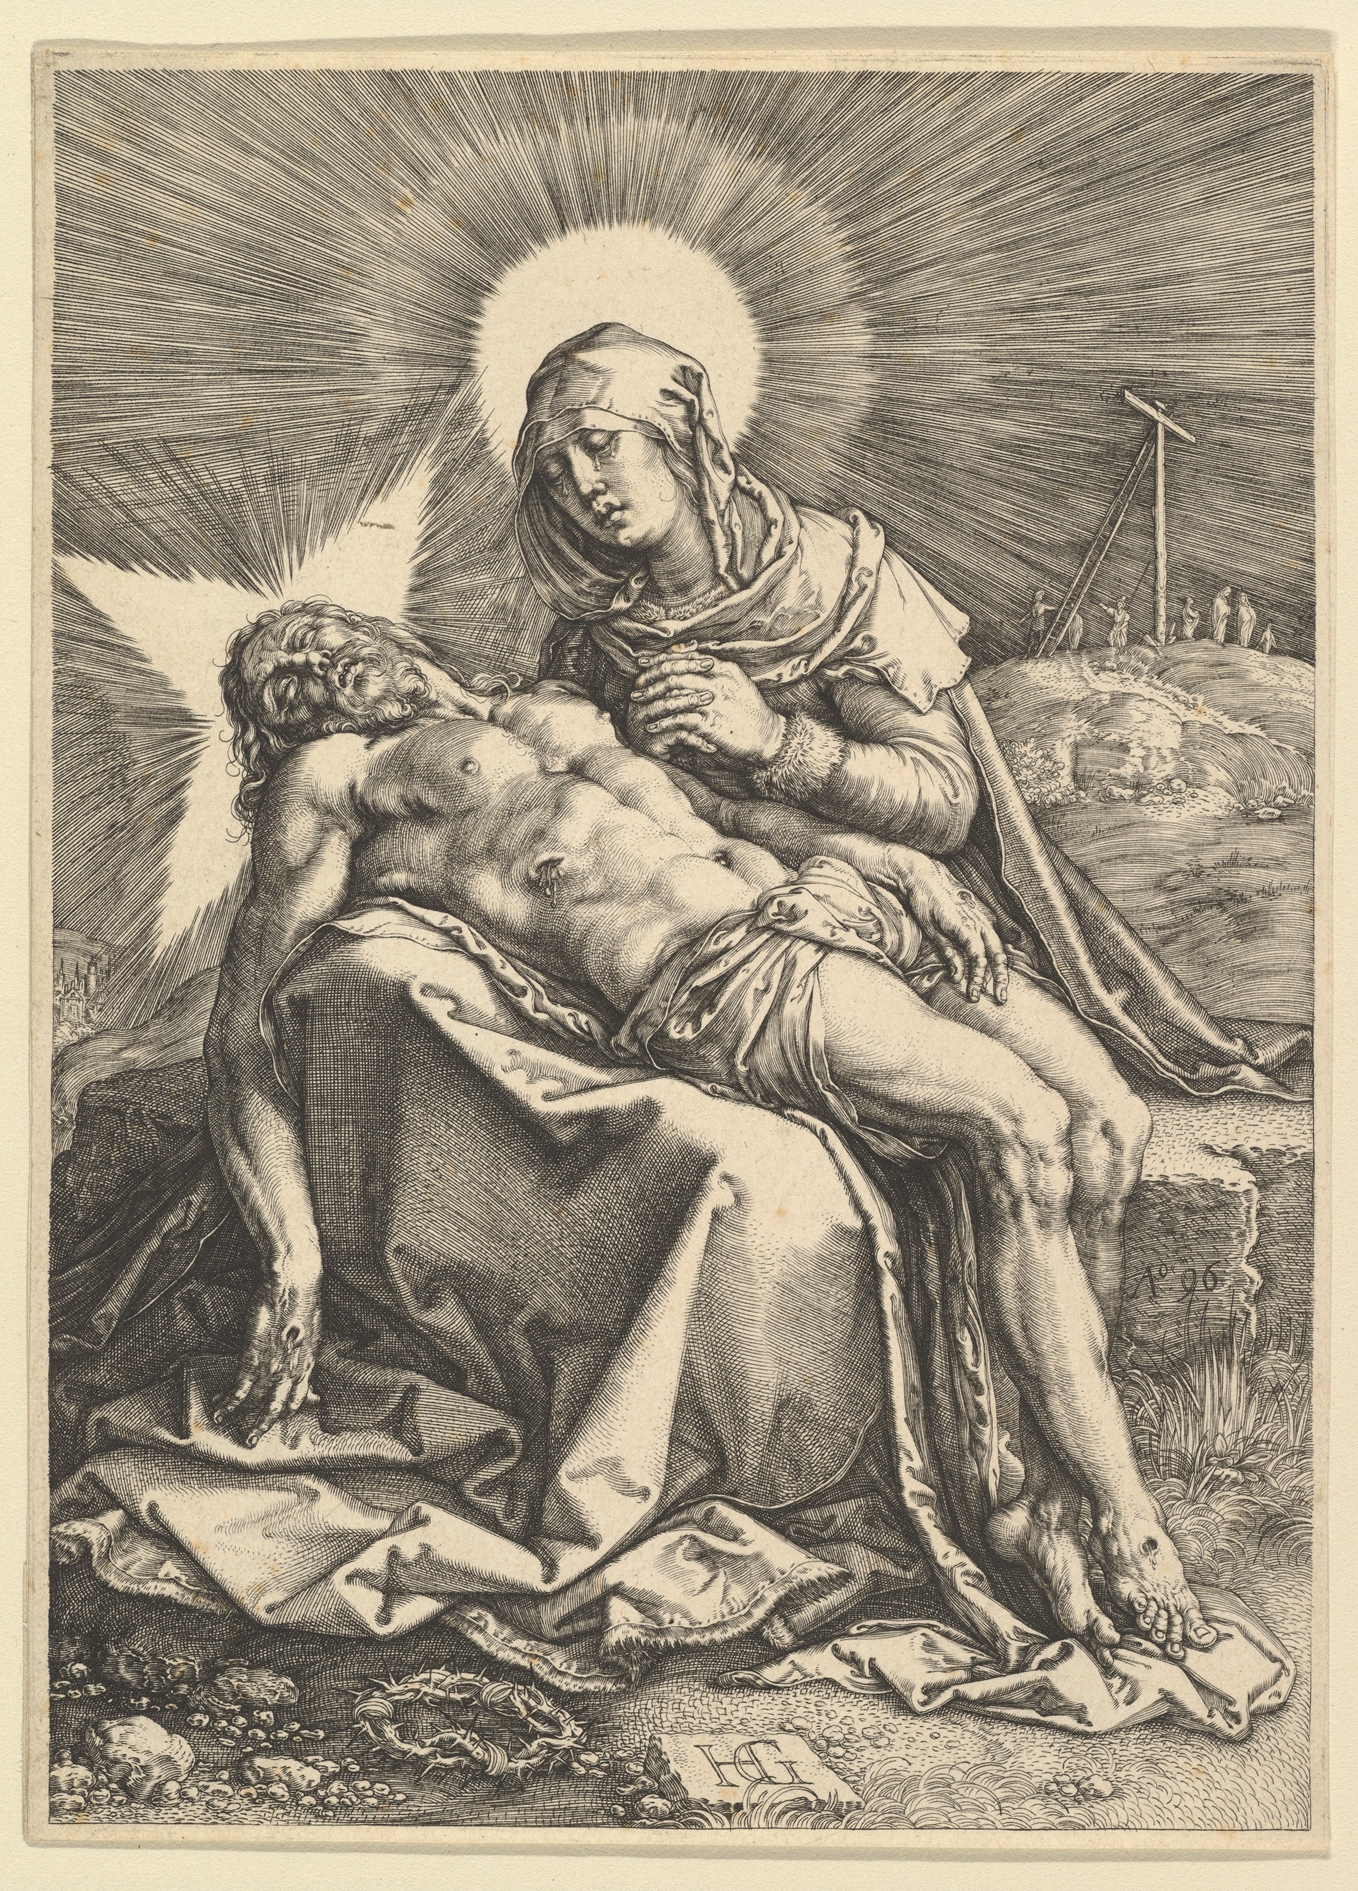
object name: print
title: Pietà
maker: hendrick goltzius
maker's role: artist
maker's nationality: netherlandish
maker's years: 1558-1617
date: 1596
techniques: engraving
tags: sadness,christ,virgin mary